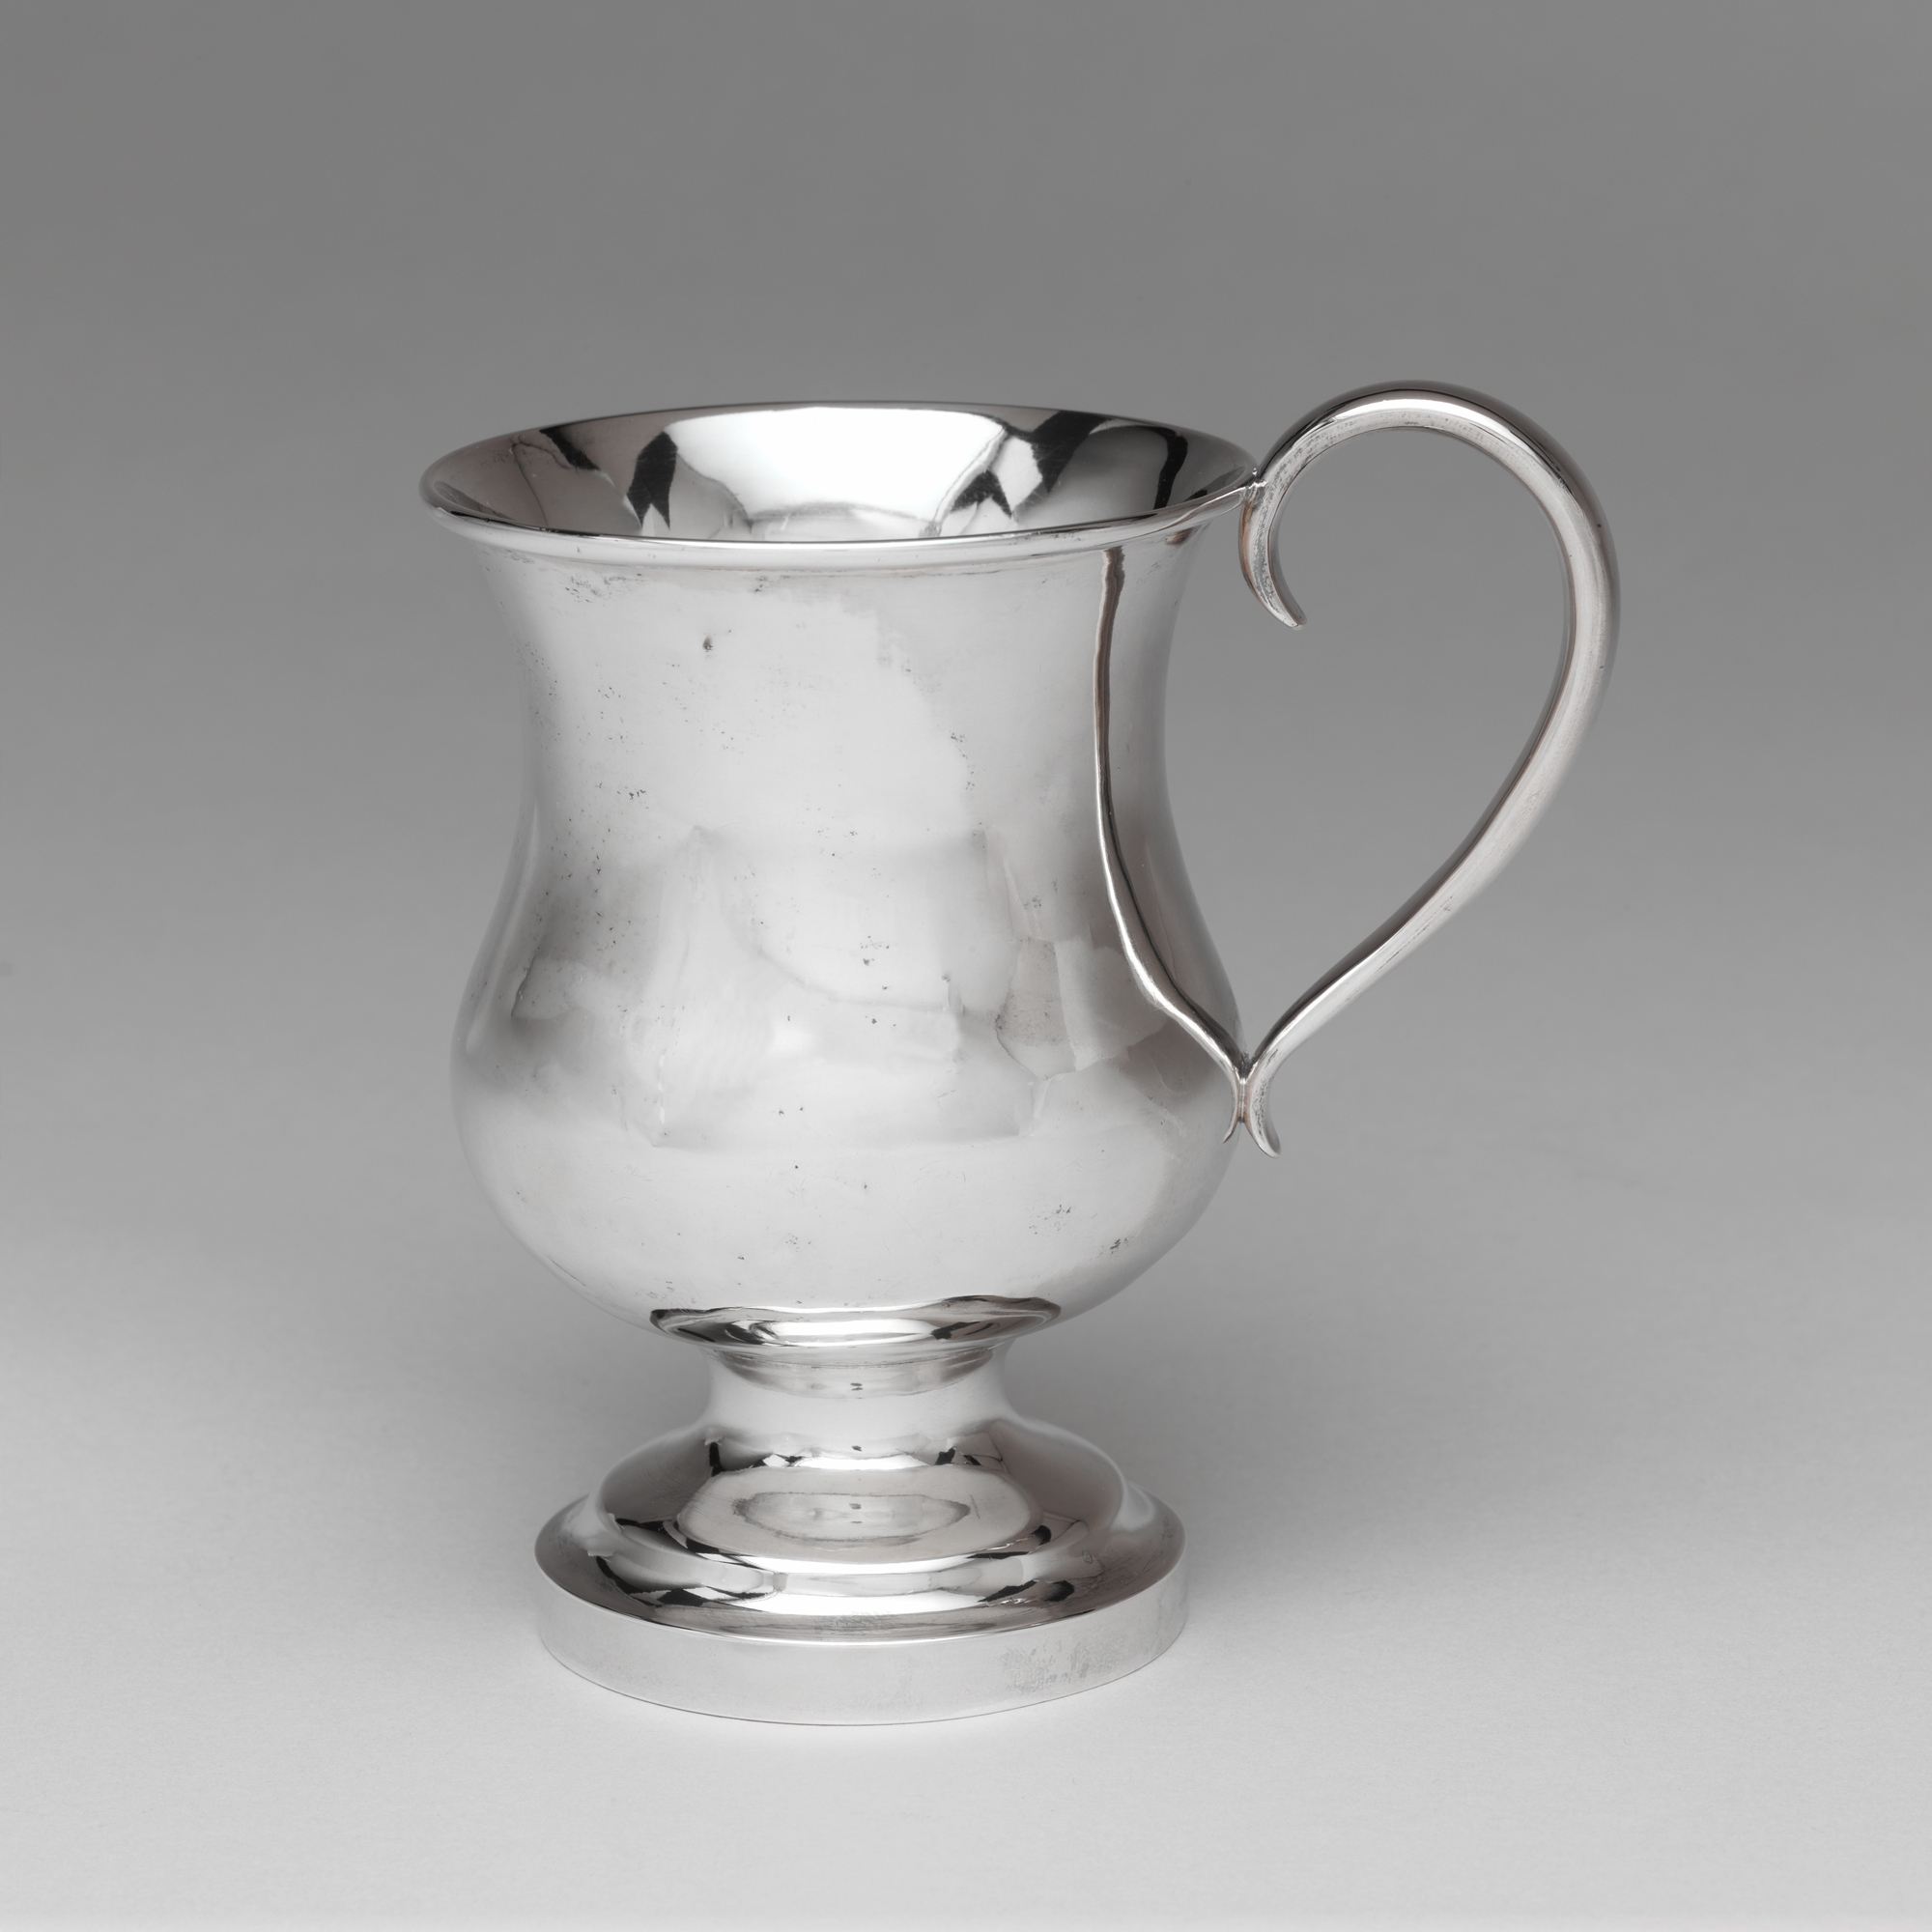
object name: mug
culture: american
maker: jones, low and ball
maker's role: maker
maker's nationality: american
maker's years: 1789-1889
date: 1825-1850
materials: silver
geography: united states